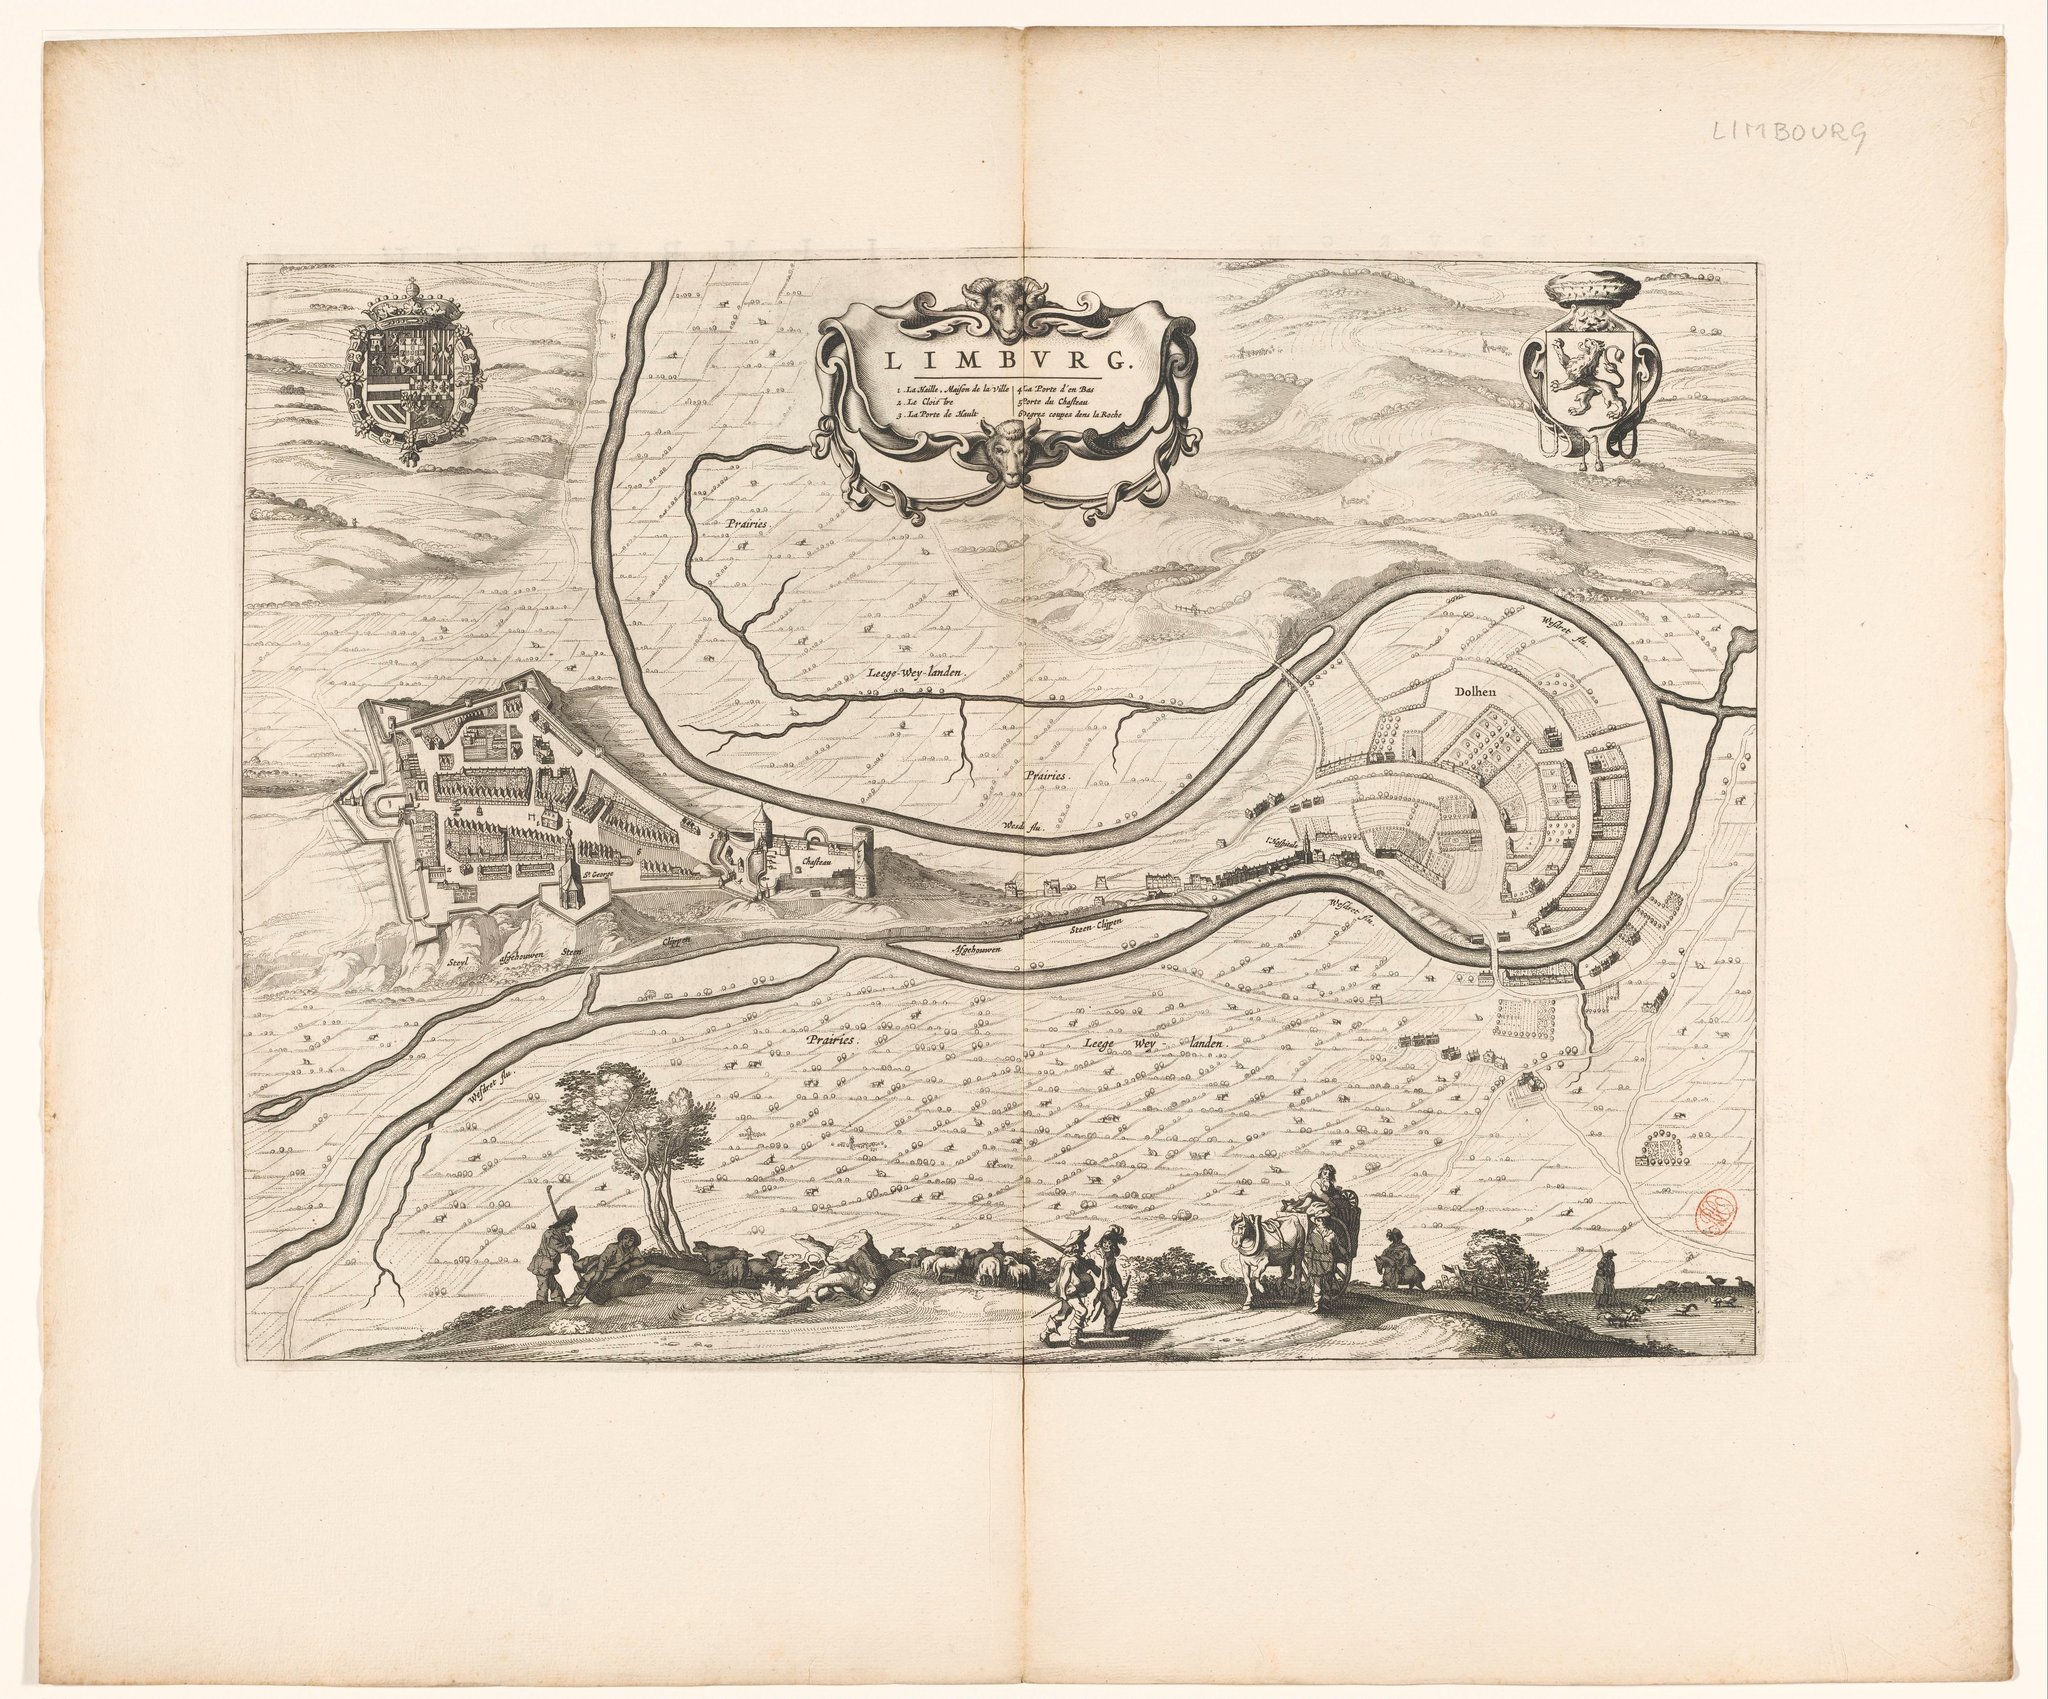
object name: area plan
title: Plattegrond van Limburg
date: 1652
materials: paper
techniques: engraving, etching, letterpress printing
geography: amsterdam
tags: fortified city, maps of cities, coat of arms (as symbol of the state, etc.) (+ province; provincial)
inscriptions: collector's mark: Lugt 195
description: Plattegrond van Limburg met gebouwen in vogelvluchtperspectief. Boven, in het midden, de titelcartouche met legenda 1-6. Linksboven het wapen van de koning van Spanje, rechtsboven het wapen van Limburg. Met Nederlandse tekst op verso.